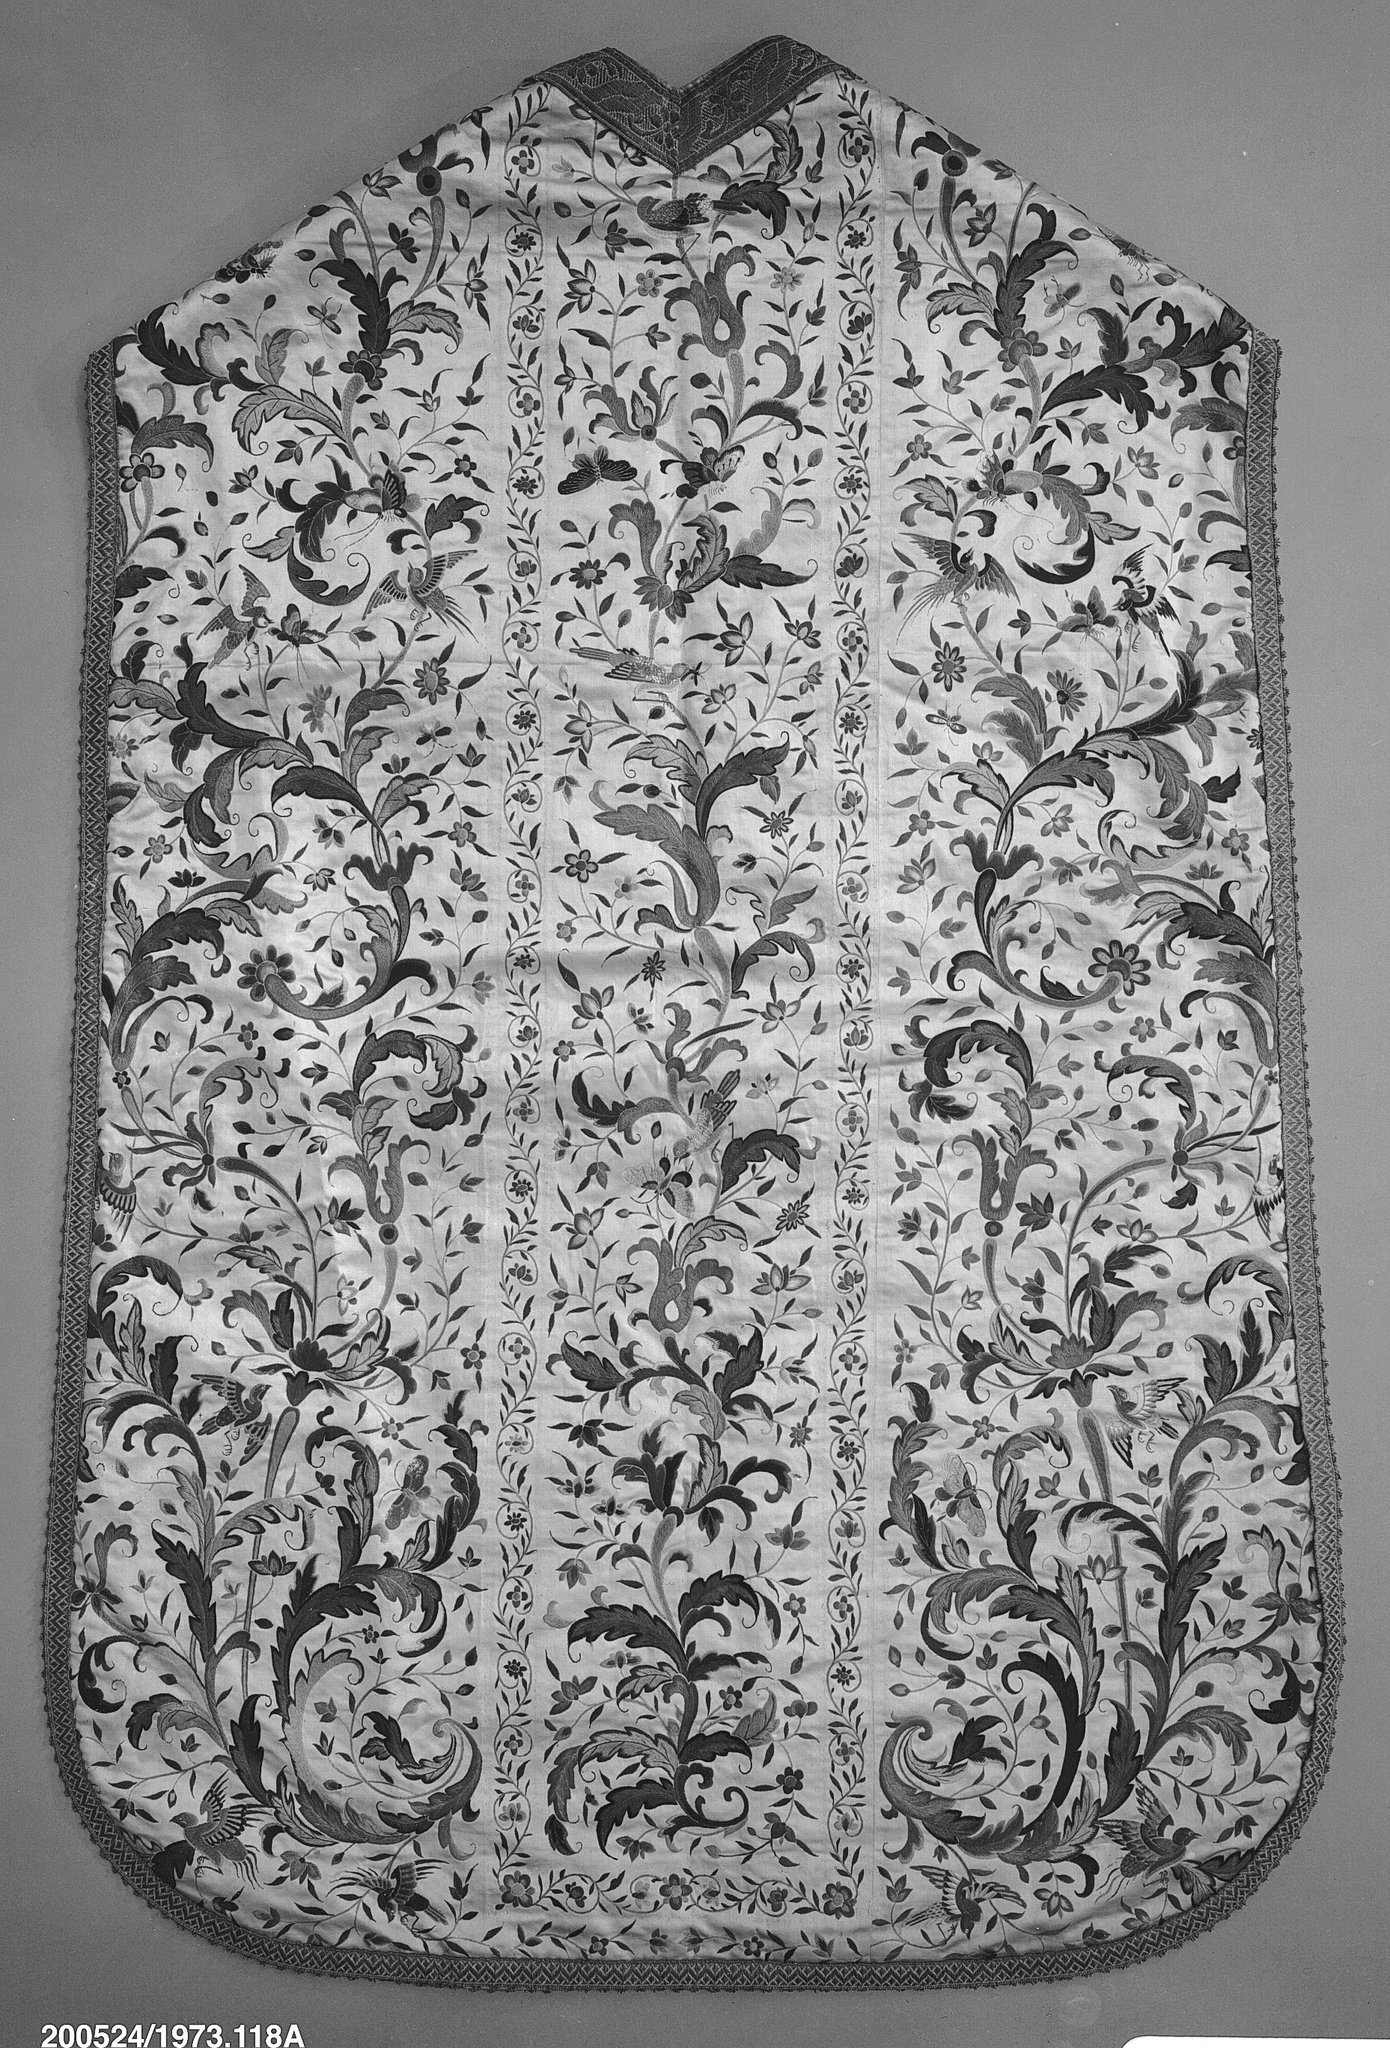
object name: chasuble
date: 1701-1733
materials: silk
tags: flowers,leaves